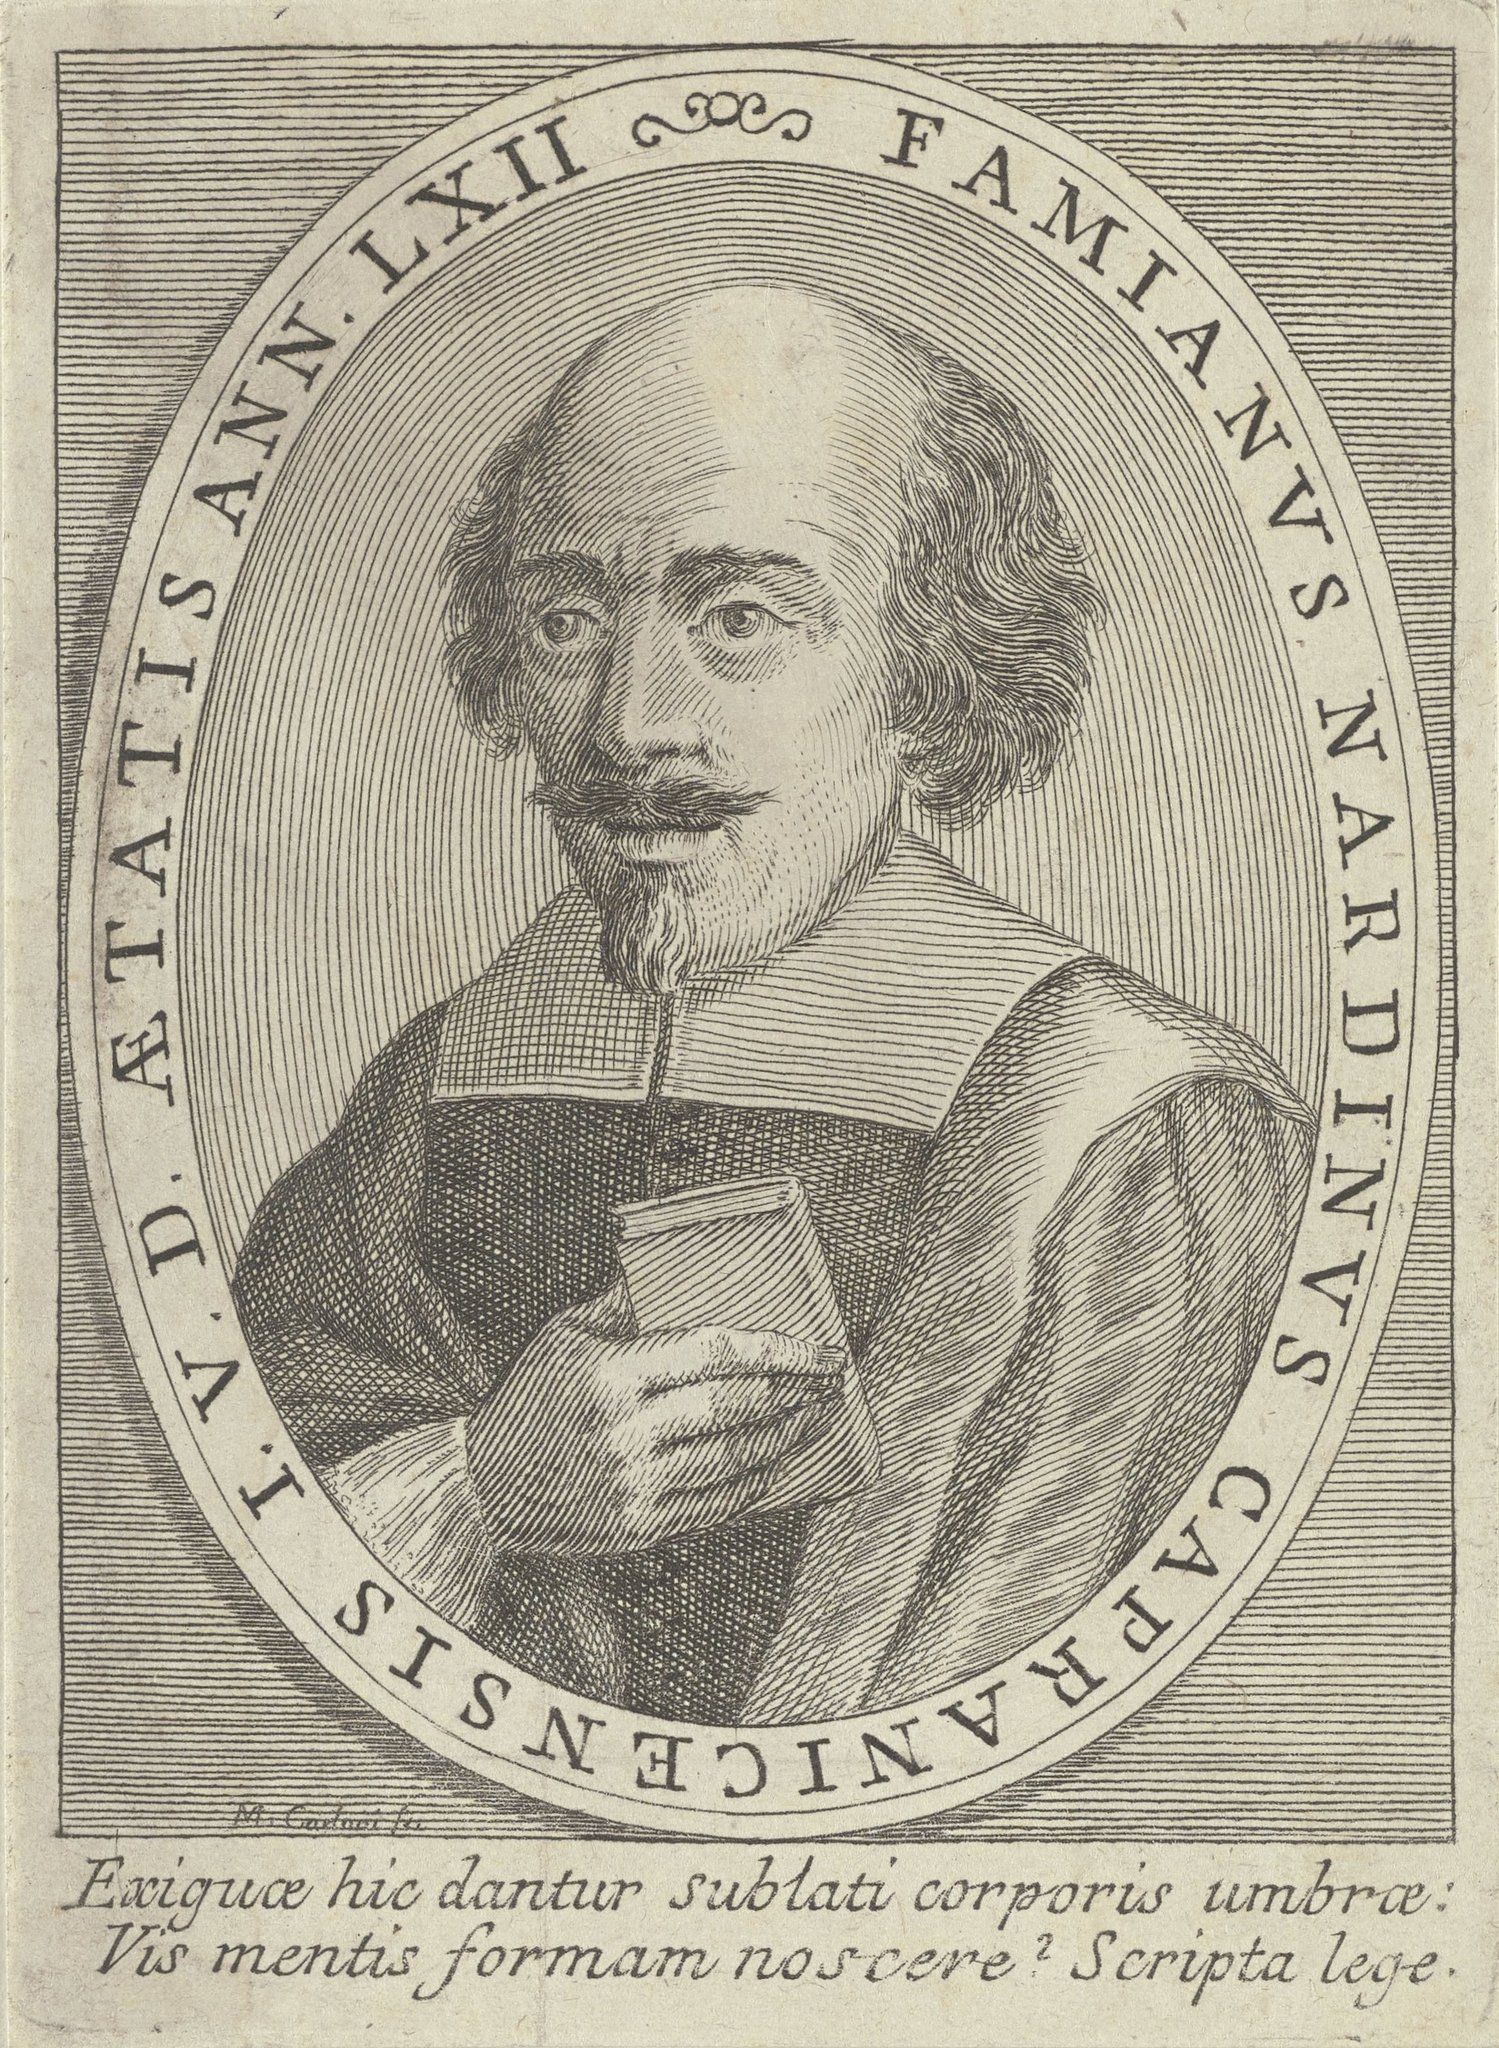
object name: print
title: Portret van Famiano Nardini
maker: marco carloni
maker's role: print maker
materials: paper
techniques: etching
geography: italy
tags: history and archaeology (+ scholar, scientist in non-work situations), historical persons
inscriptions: collector's mark: Lugt 2228